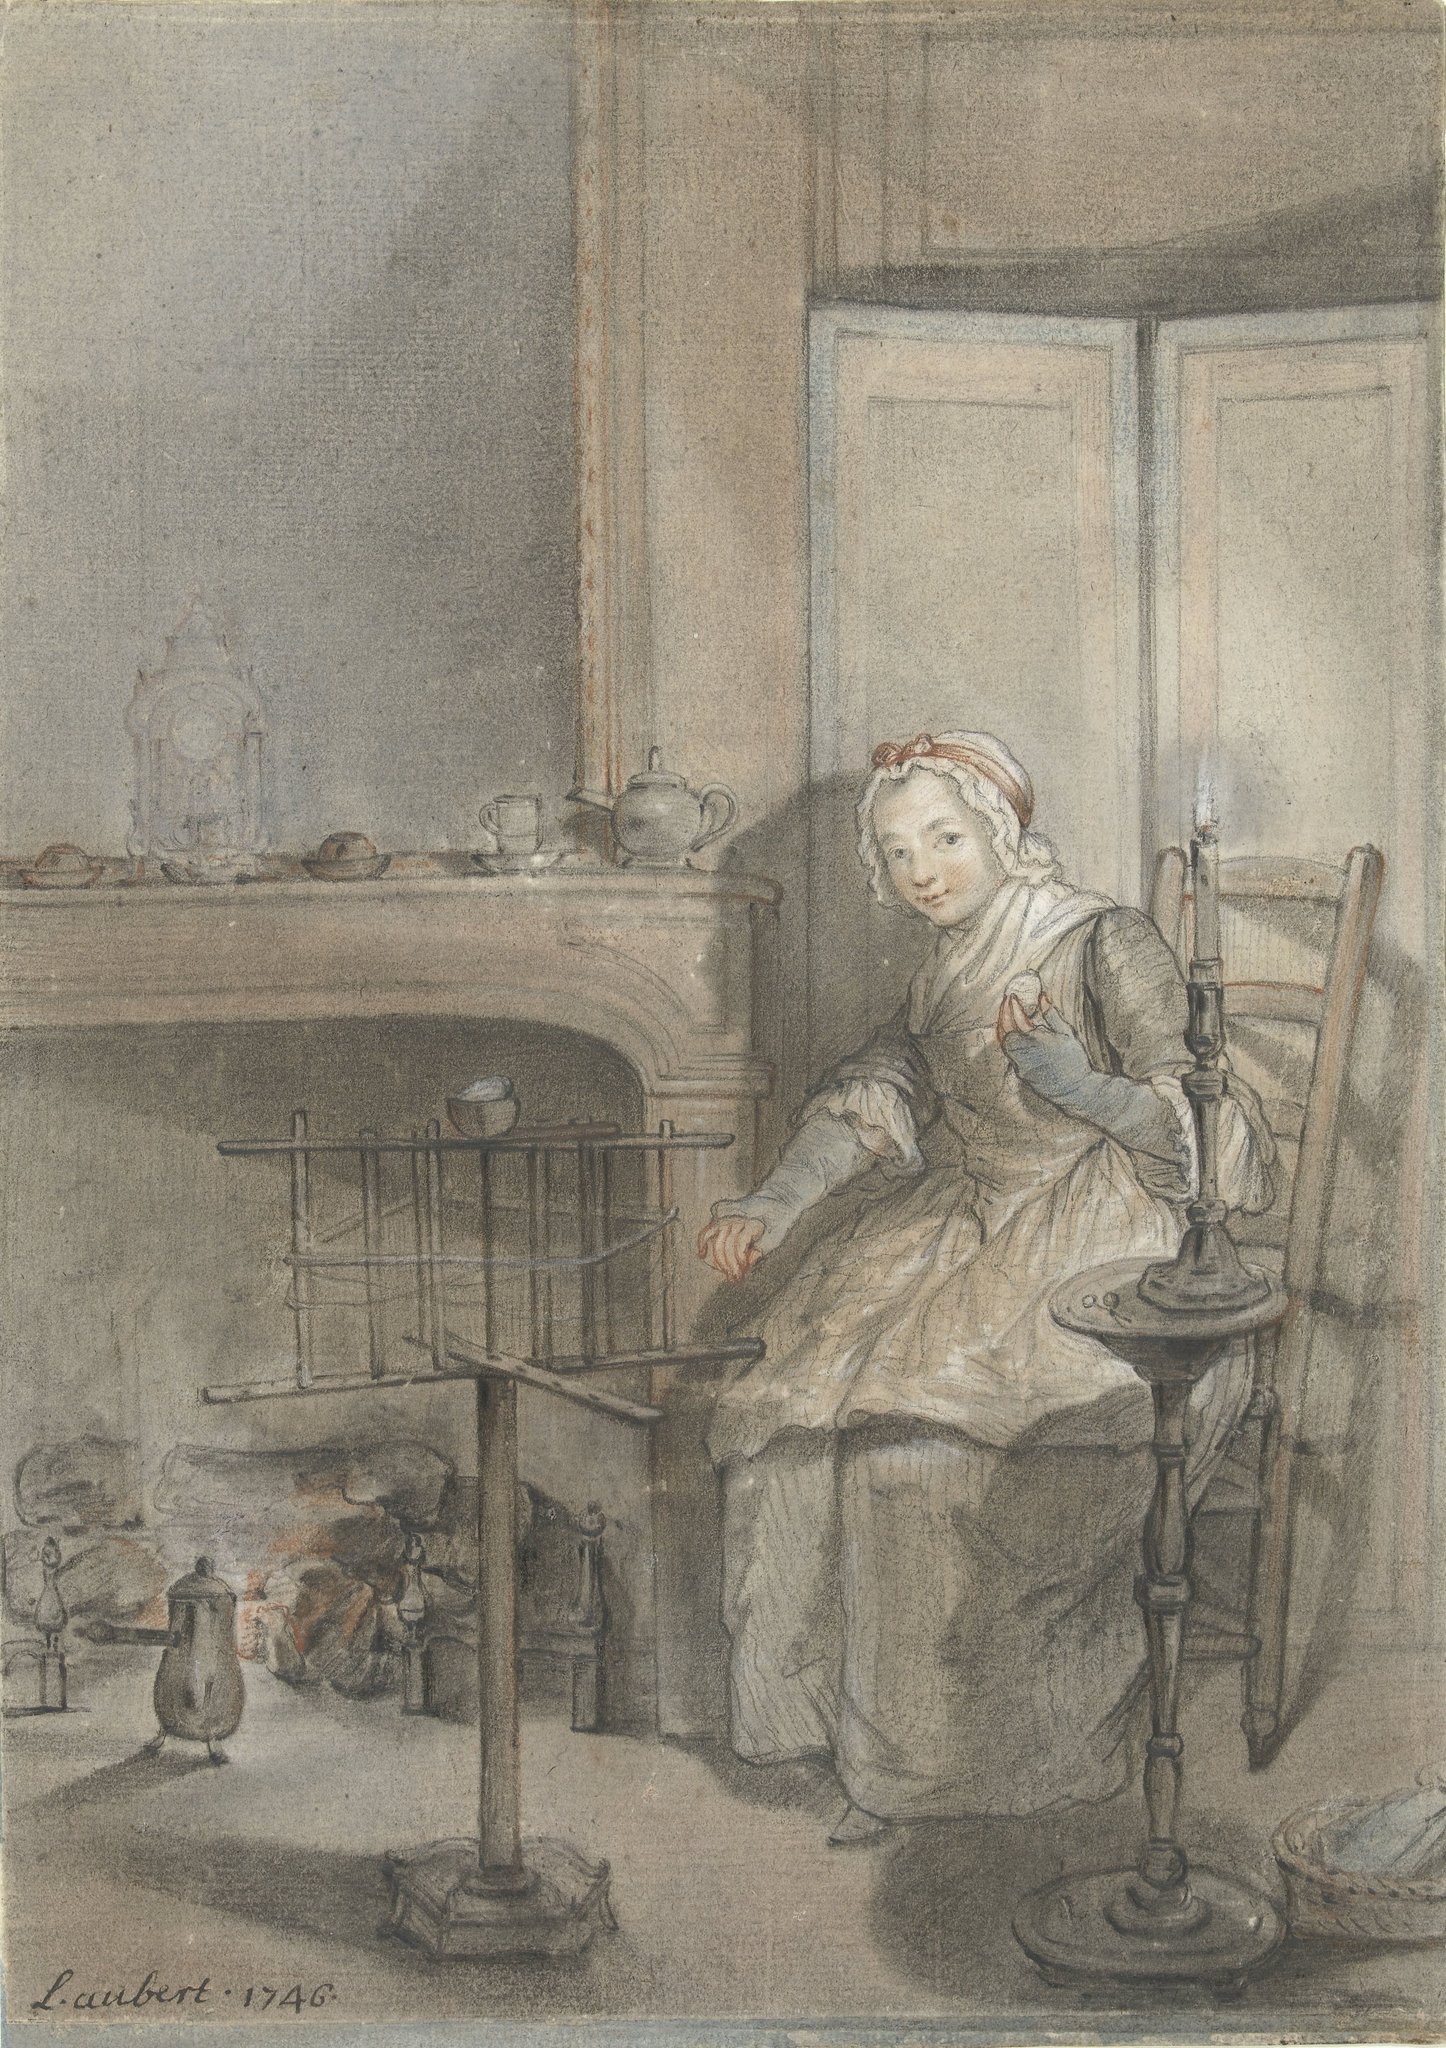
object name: drawing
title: Interieur met een wolkluwende jonge vrouw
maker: louis aubert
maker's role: draughtsman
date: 1746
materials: chalk, paper, pencil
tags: head-gear: cap (+ women's clothes), dress, gown (+ women's clothes), wool (material ~ textile industry)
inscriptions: collector's mark, verso, lower left: Lugt 2228, collector's mark: Lugt 1508, signature and date, recto, lower left, pen and black ink: ‘L. aubert. 1746.’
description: In een interieur met open haard en kamerscherm zit een jonge vrouw wol op een kluwen te draaien. Naast haar een brandende kaars in kandelaar op rond tafeltje. Ze is gekleed als dienstbode of draagt burgerlijke kleding ca. 1746. Mutsje met strikje op het hoofd.